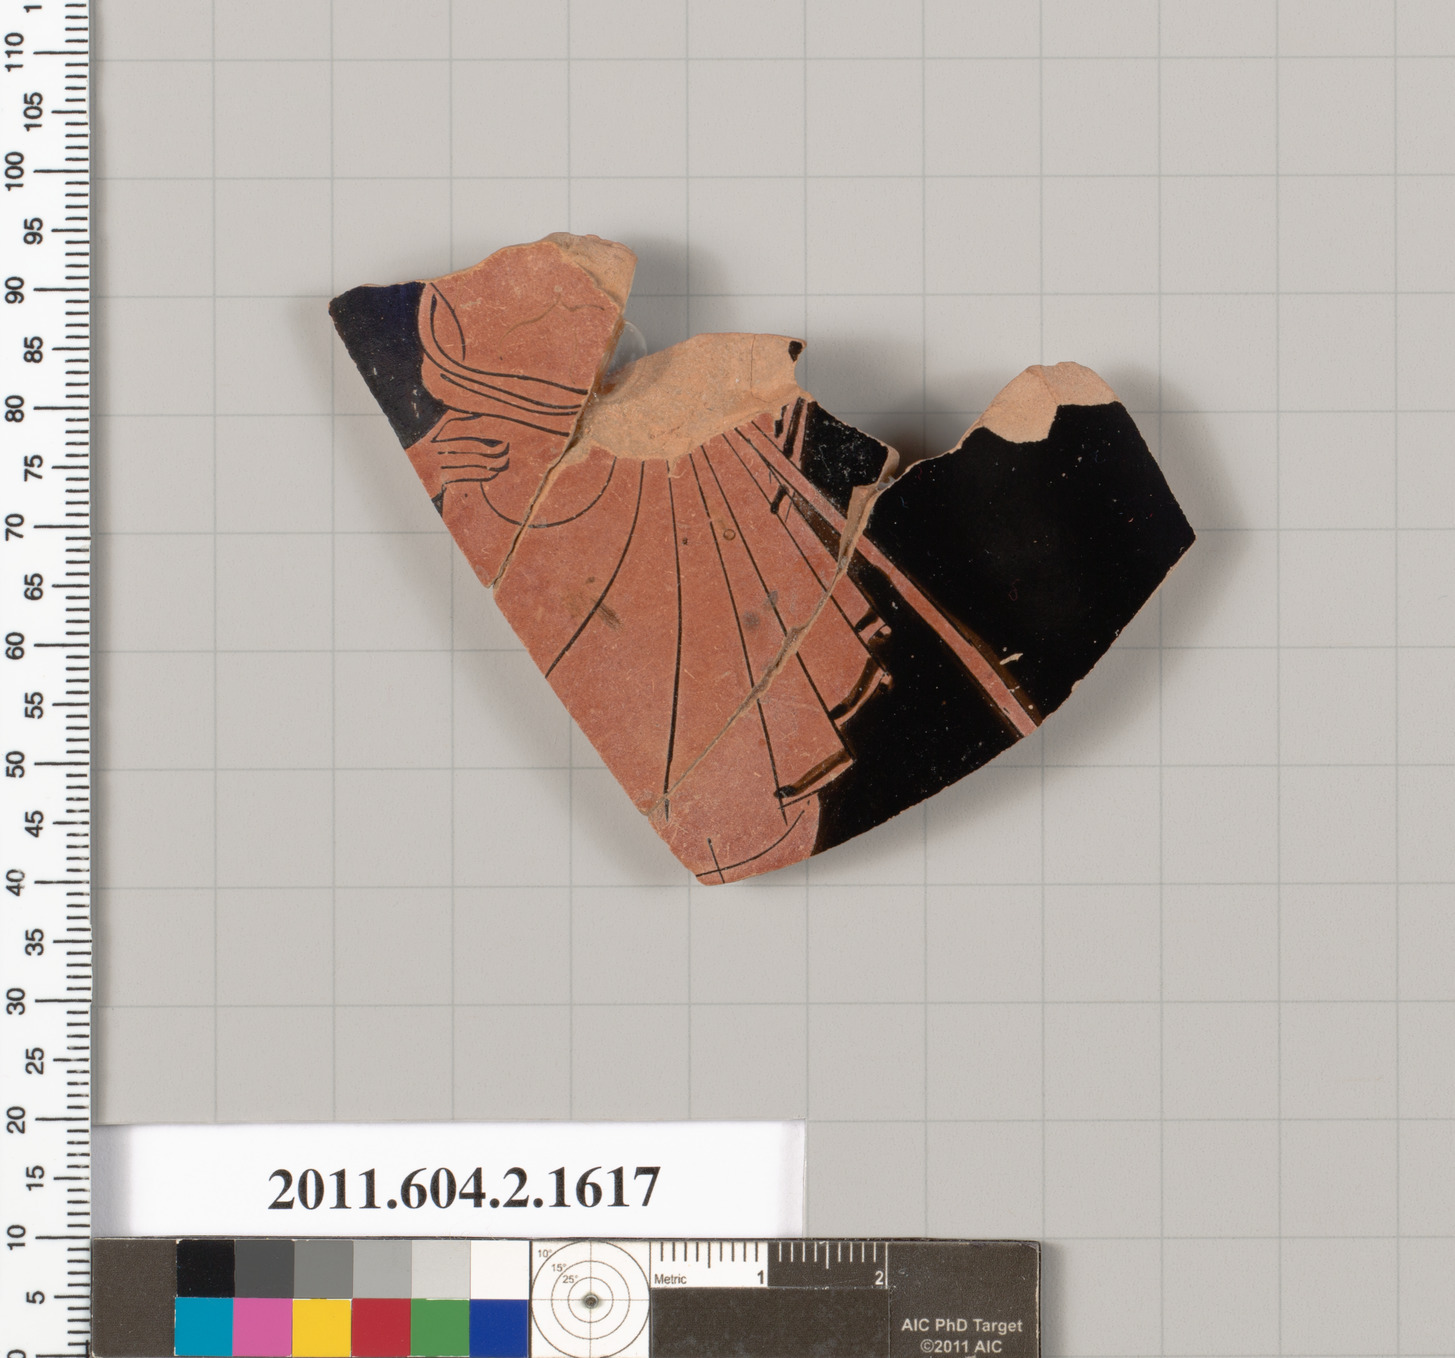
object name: skyphos fragment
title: Terracotta fragment of a skyphos (deep drinking cup)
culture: greek, attic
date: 460-440 BCE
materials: terracotta